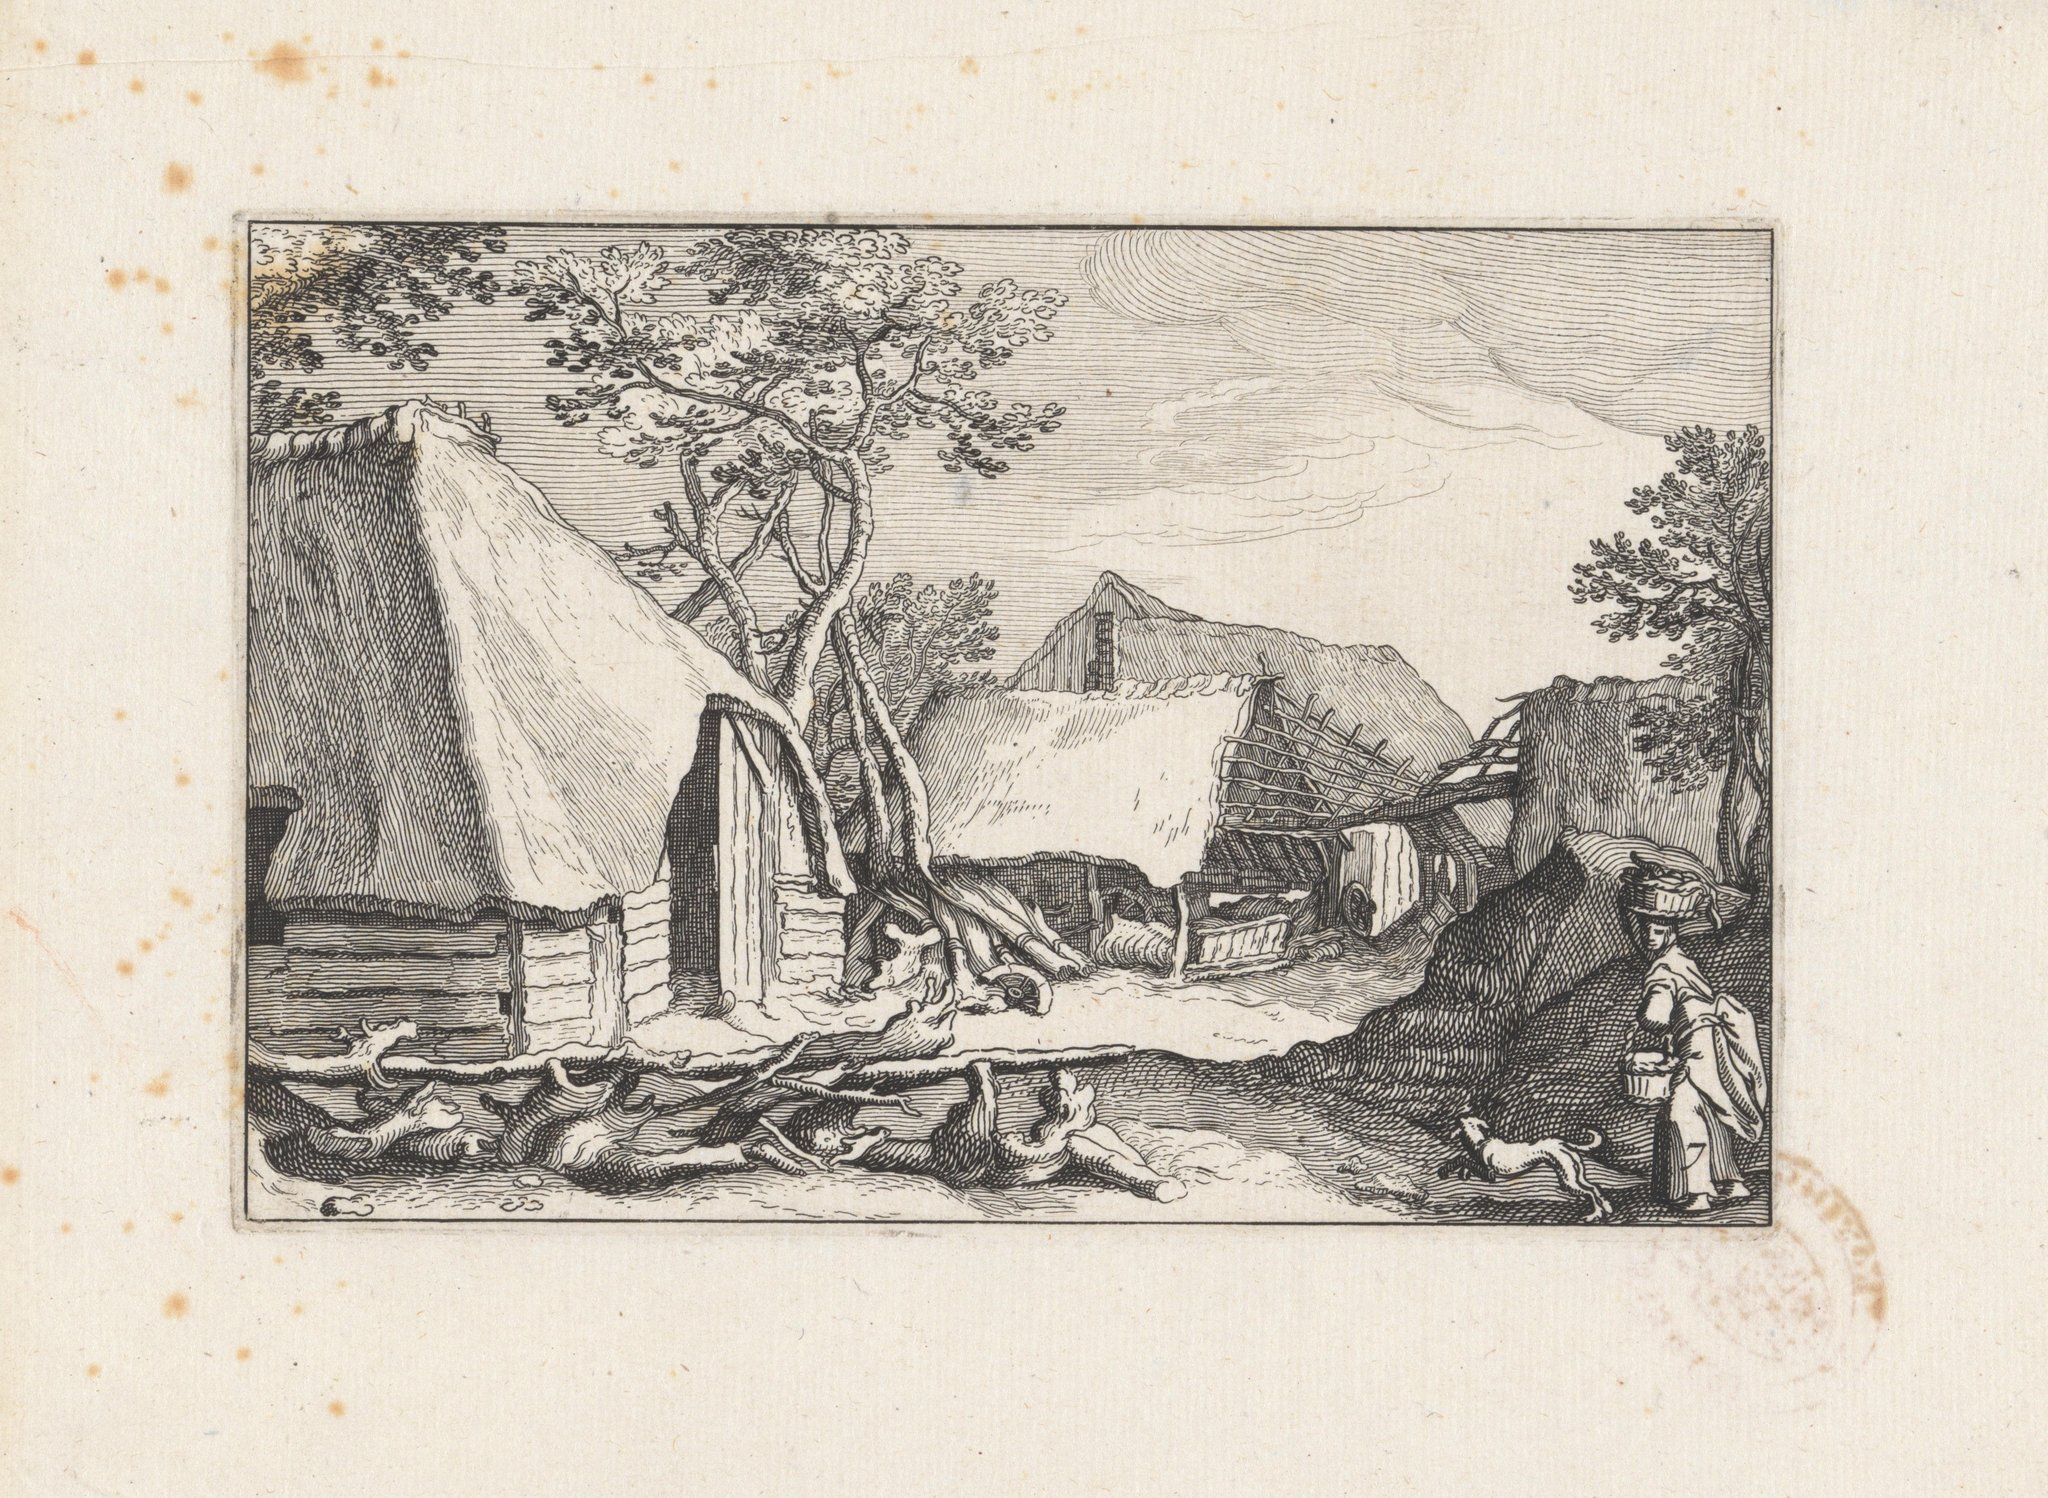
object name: print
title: Landschappen met boerderijen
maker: claes jansz. visscher (ii)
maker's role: draughtsman, print maker, publisher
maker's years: 1586-1652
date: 1620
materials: paper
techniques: etching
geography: amsterdam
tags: farm or solitary house in landscape, farm (building), dog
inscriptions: collector's mark: Lugt 240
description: Gezicht op een boerderij met een erf. Rechts op de voorgrond een vrouw en een hond. Op de achtergrond staat een vervallen schuur.